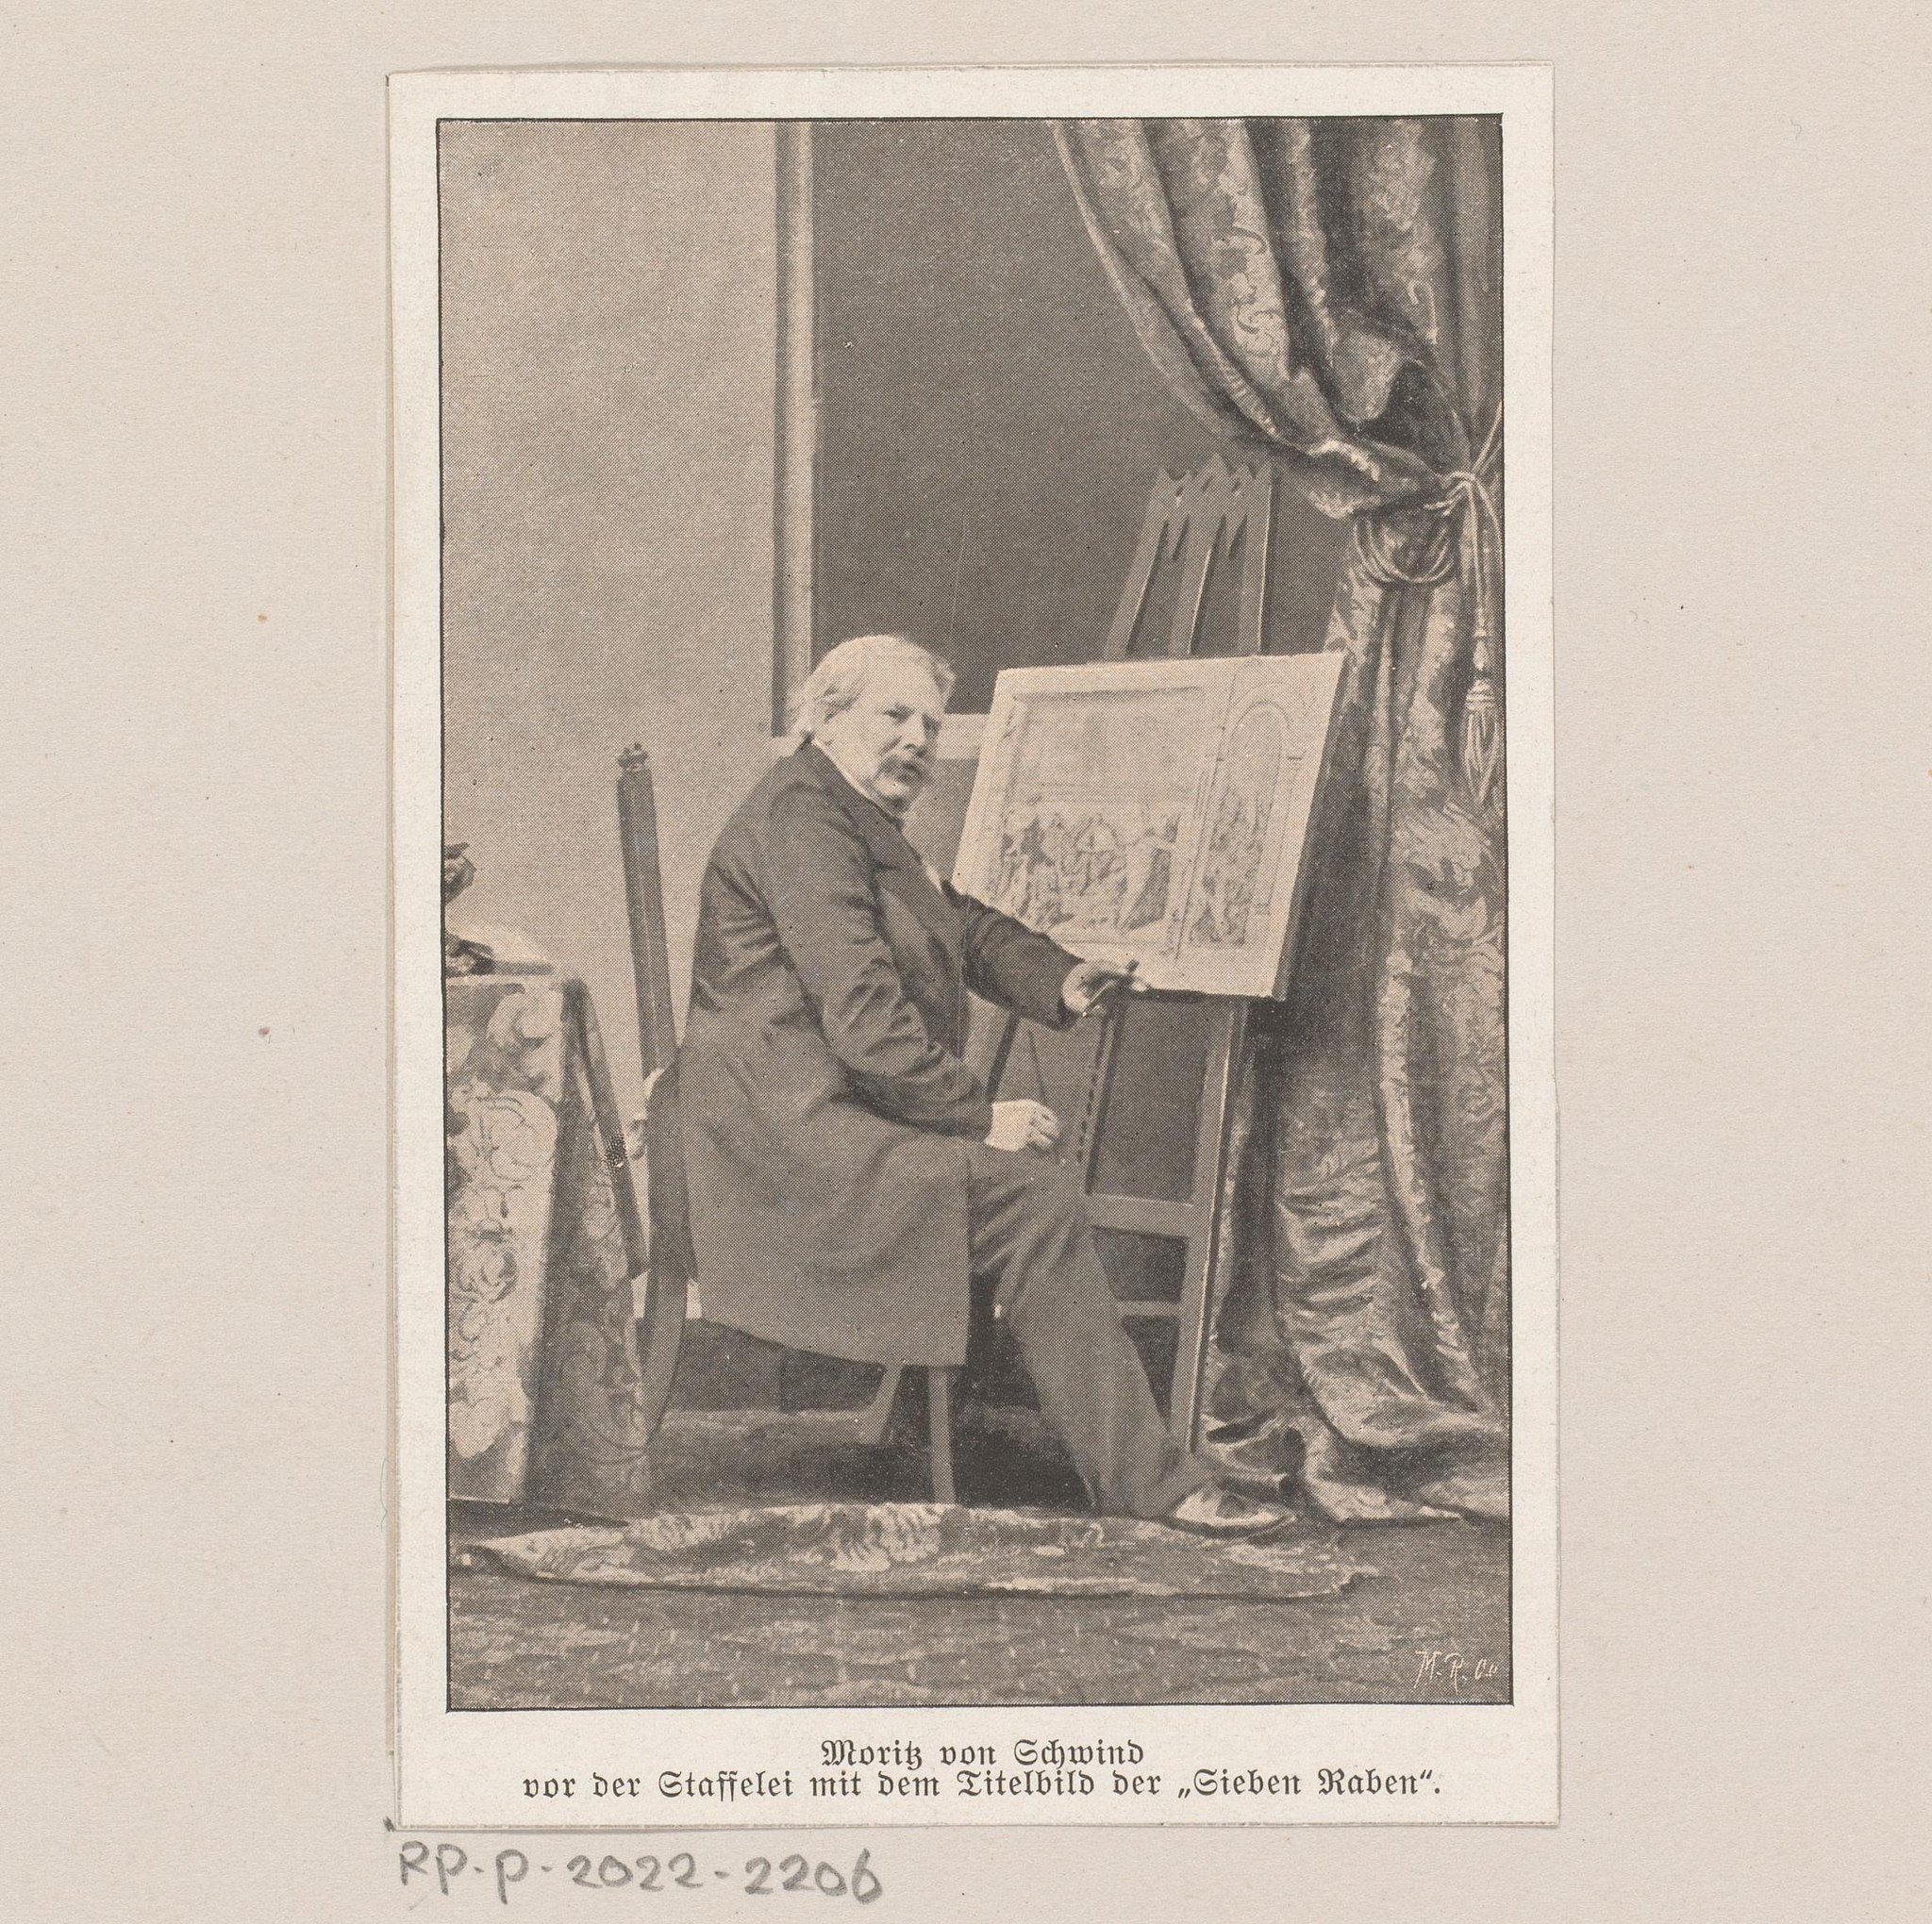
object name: photomechanical print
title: Portret van Moritz von Schwind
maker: Anonymous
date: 1882-1970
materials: paper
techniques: autotype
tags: vienna, print maker, draughtsman, moritz von schwind, historical persons, portrait, self-portrait of artist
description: Fotomechanische afdruk uit een onbekende publicatie.